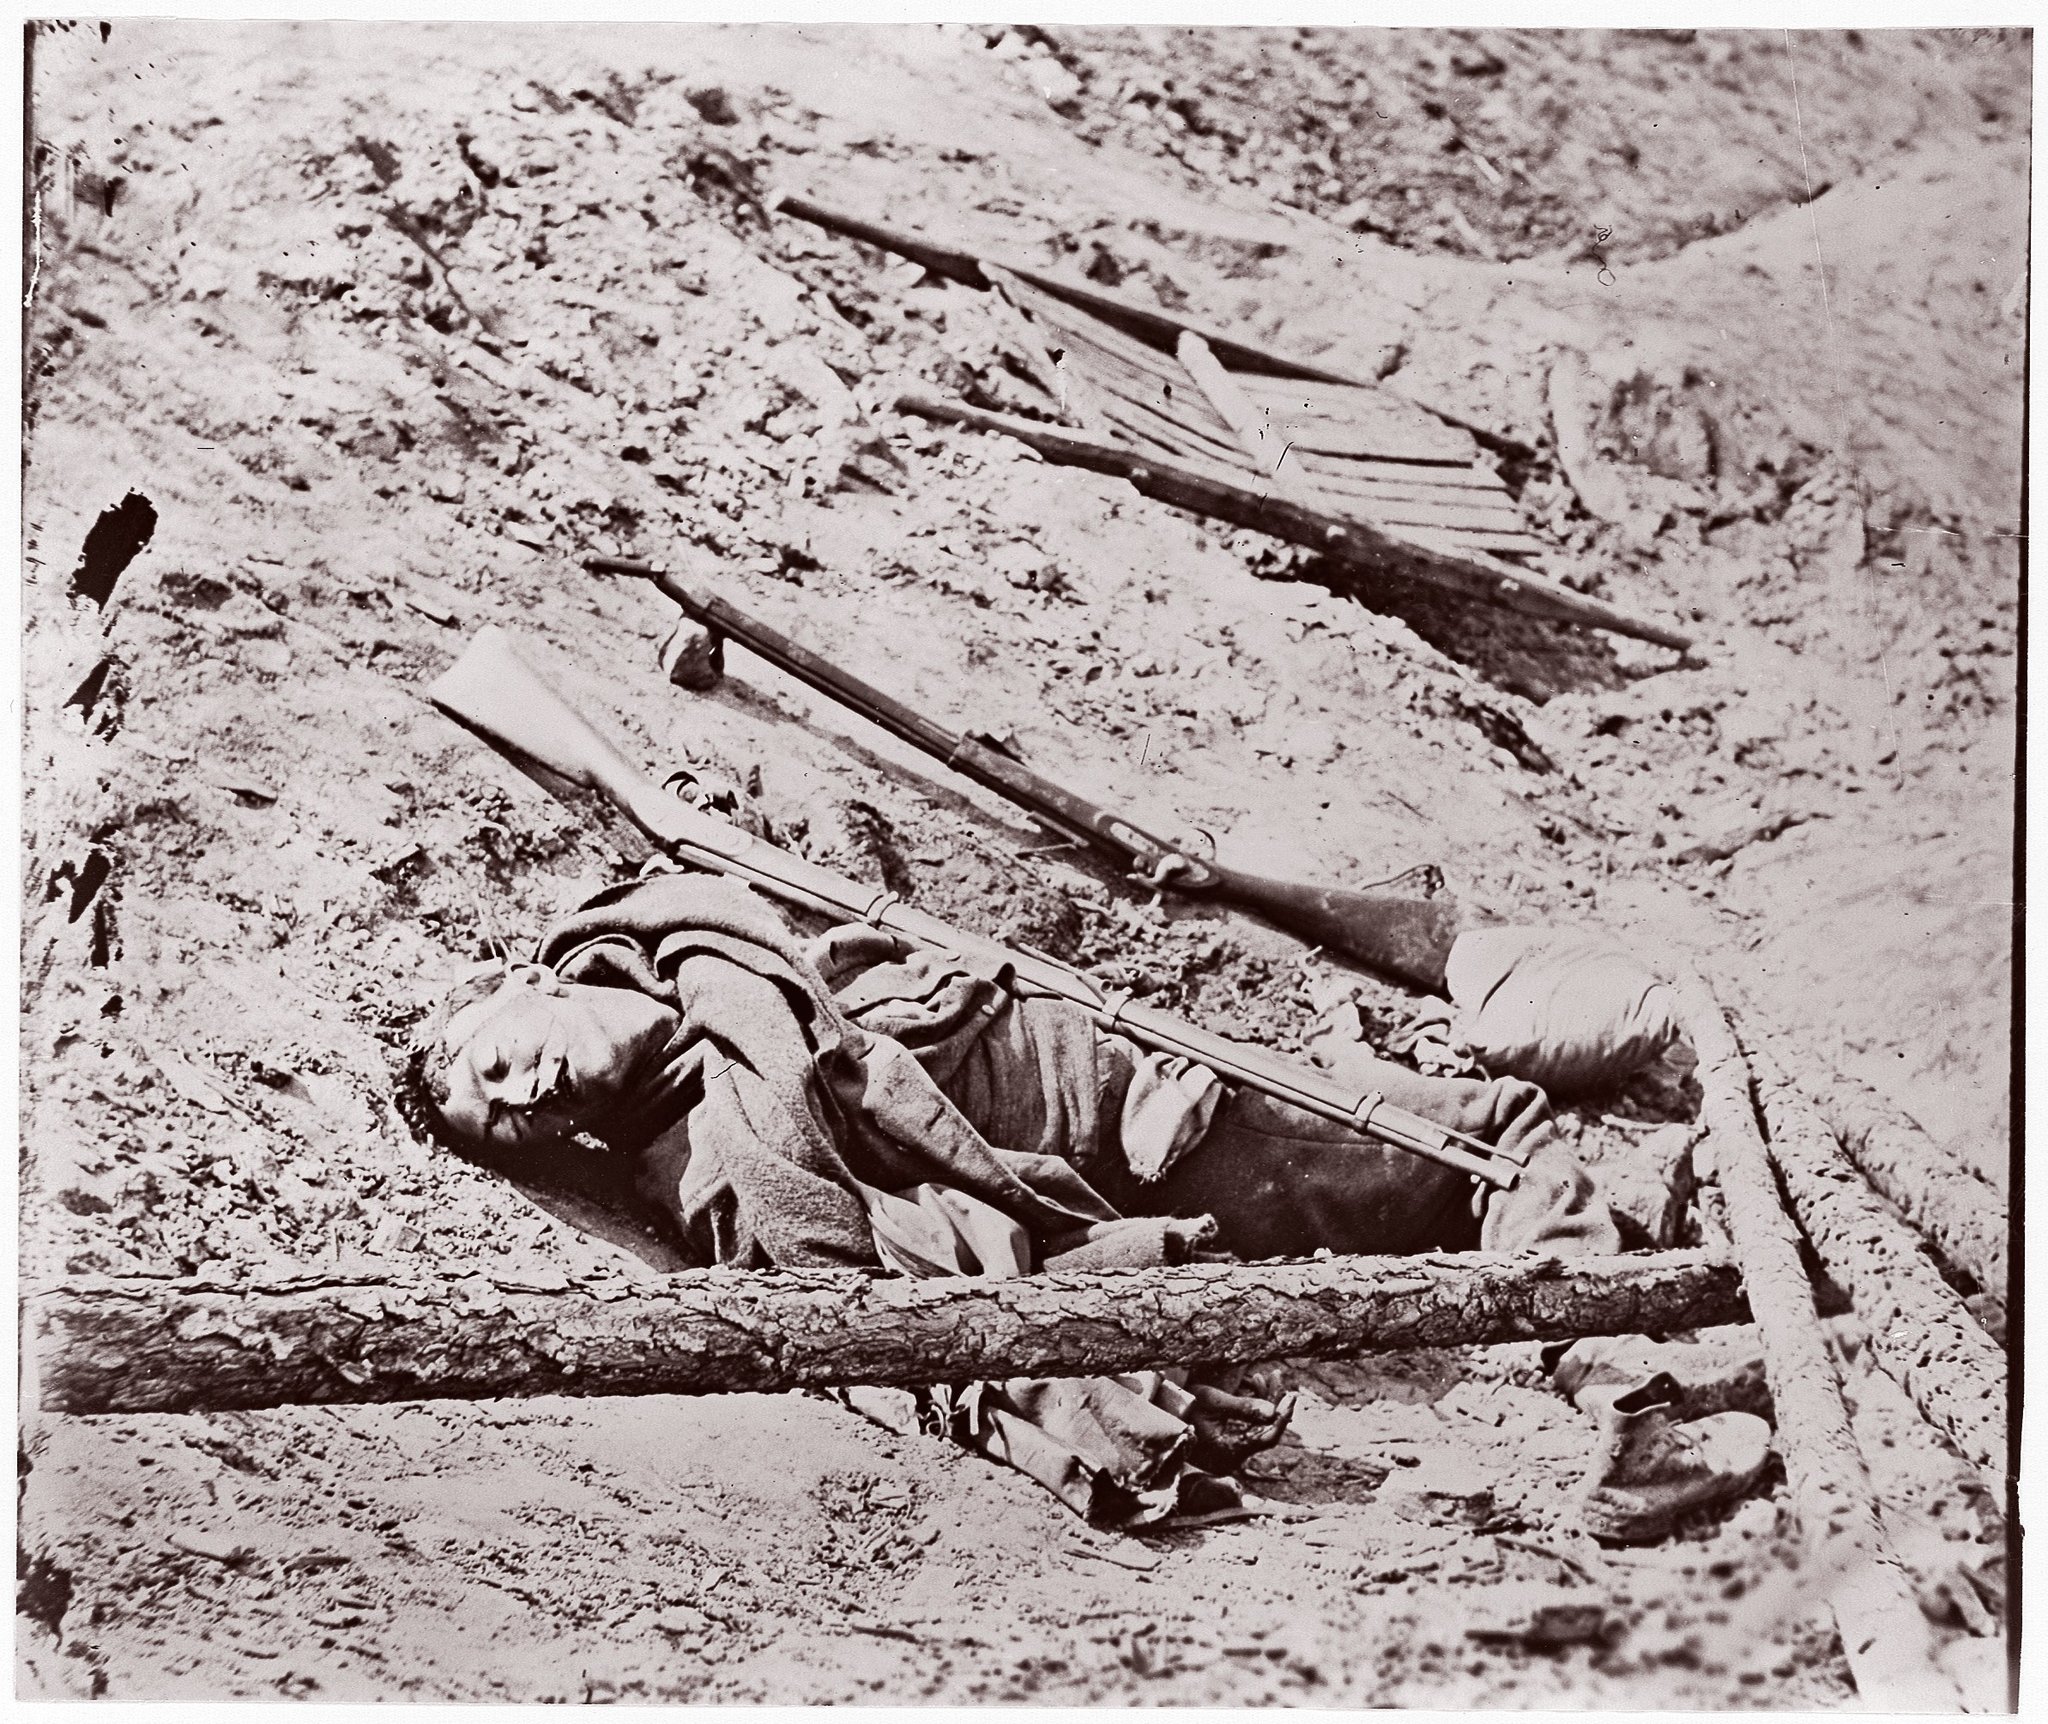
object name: photograph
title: Dead Confederate Soldier at Fort Mahone, Petersburg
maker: thomas c. roche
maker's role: artist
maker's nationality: american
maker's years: 1826-1895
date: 1864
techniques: albumen silver print, glass negative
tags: soldiers,american civil war,corpses